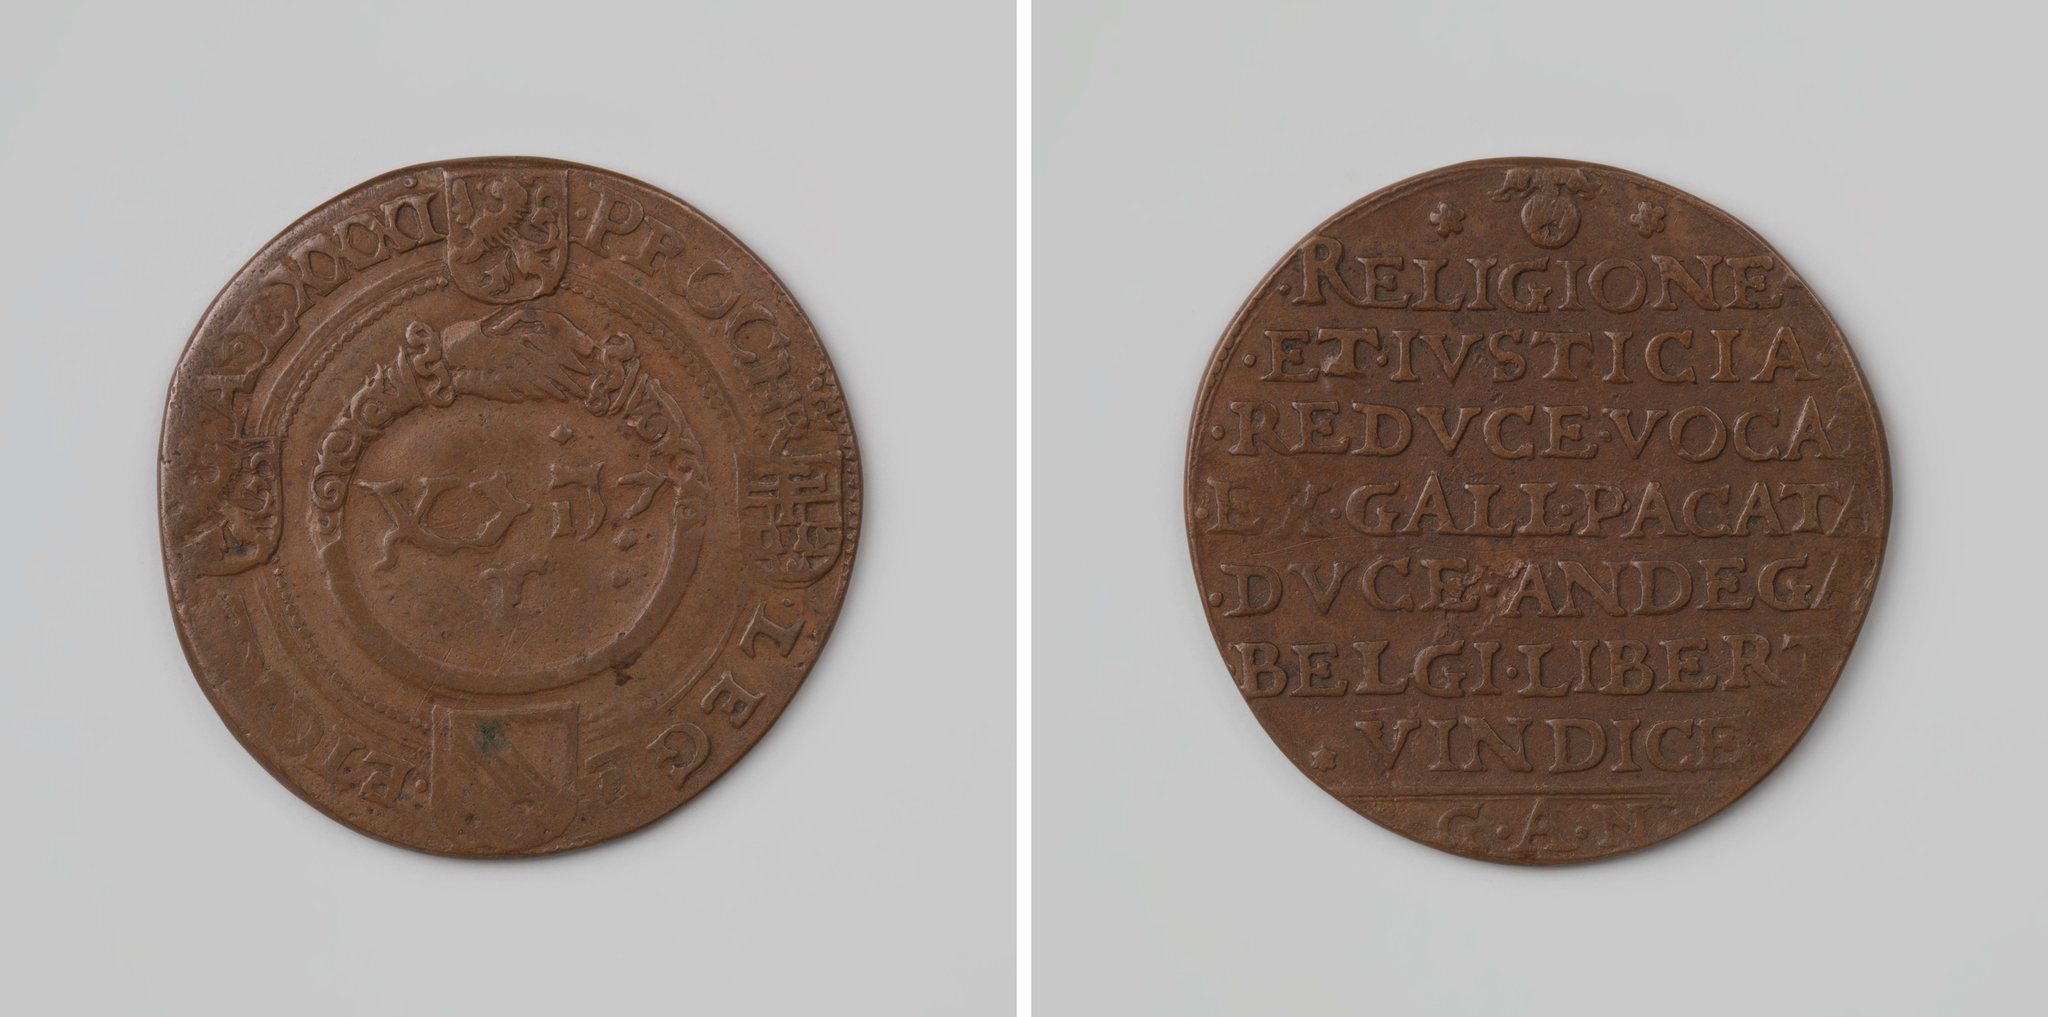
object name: jeton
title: Francois-Hercule, hertog van Anjou door de Vier Leden van Vlaanderen als landsheer aanvaard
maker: Anonymous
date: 1581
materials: copper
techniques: striking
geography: ghent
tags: paris, françois-hercule de valois (hertog van anjou)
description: Koperen penning. Voorzijde: naam Jehovah in Hebreeuws schrift binnen cirkel, die aan bovenzijde eindigt in twee ineen geslagen handen binnen omschrift, onderbroken door vier wapenschilden. Keerzijde: opschrift